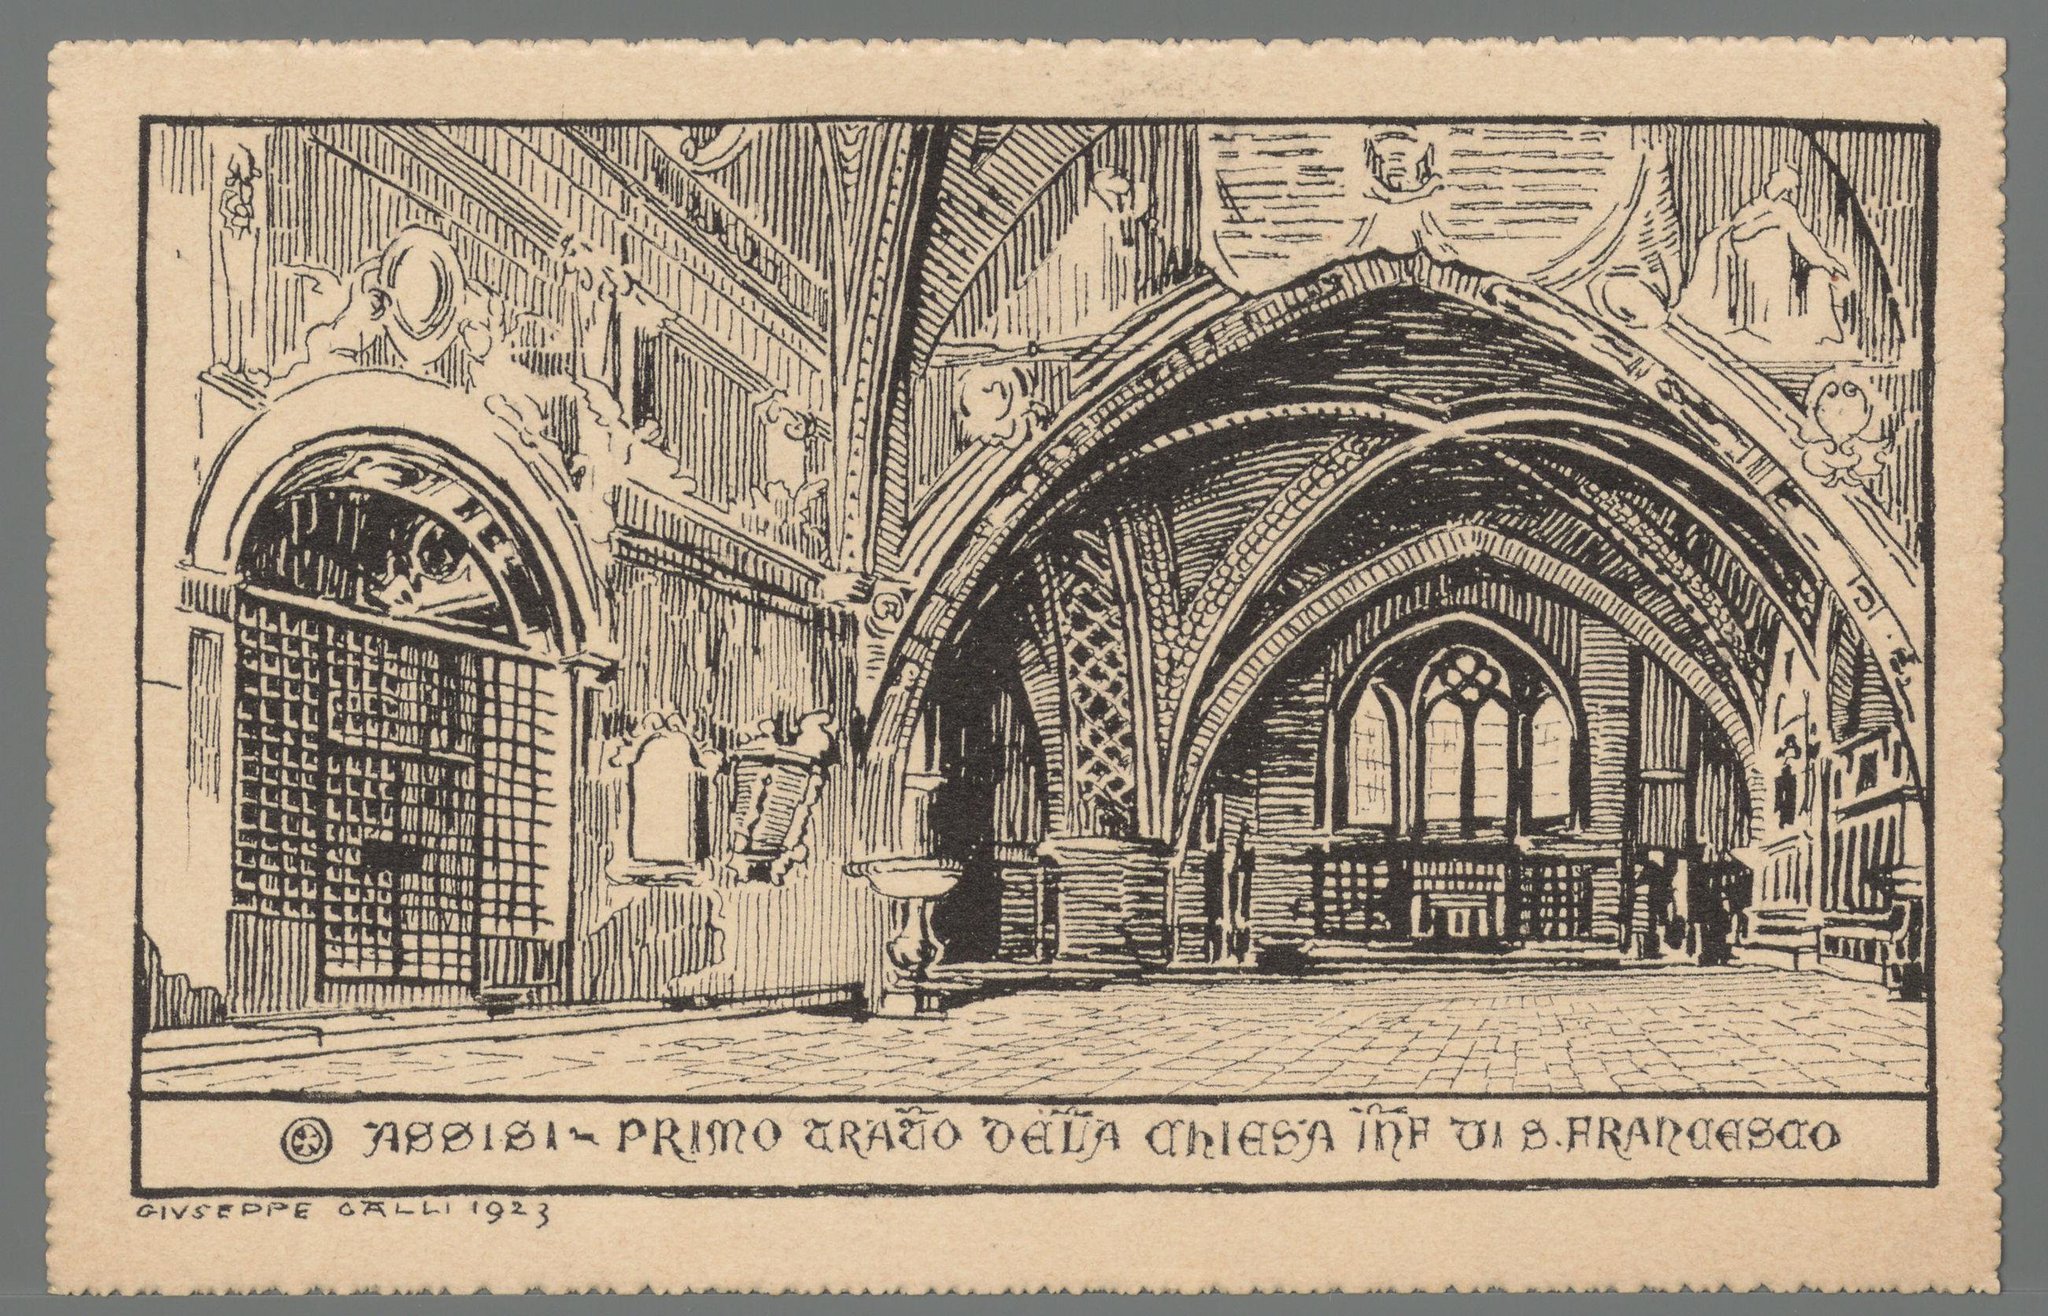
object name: photomechanical print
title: Assisi. Primo tratto della Chiesa inf. di S. Francesco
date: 1923-1930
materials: cardboard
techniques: photograph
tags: interior of church